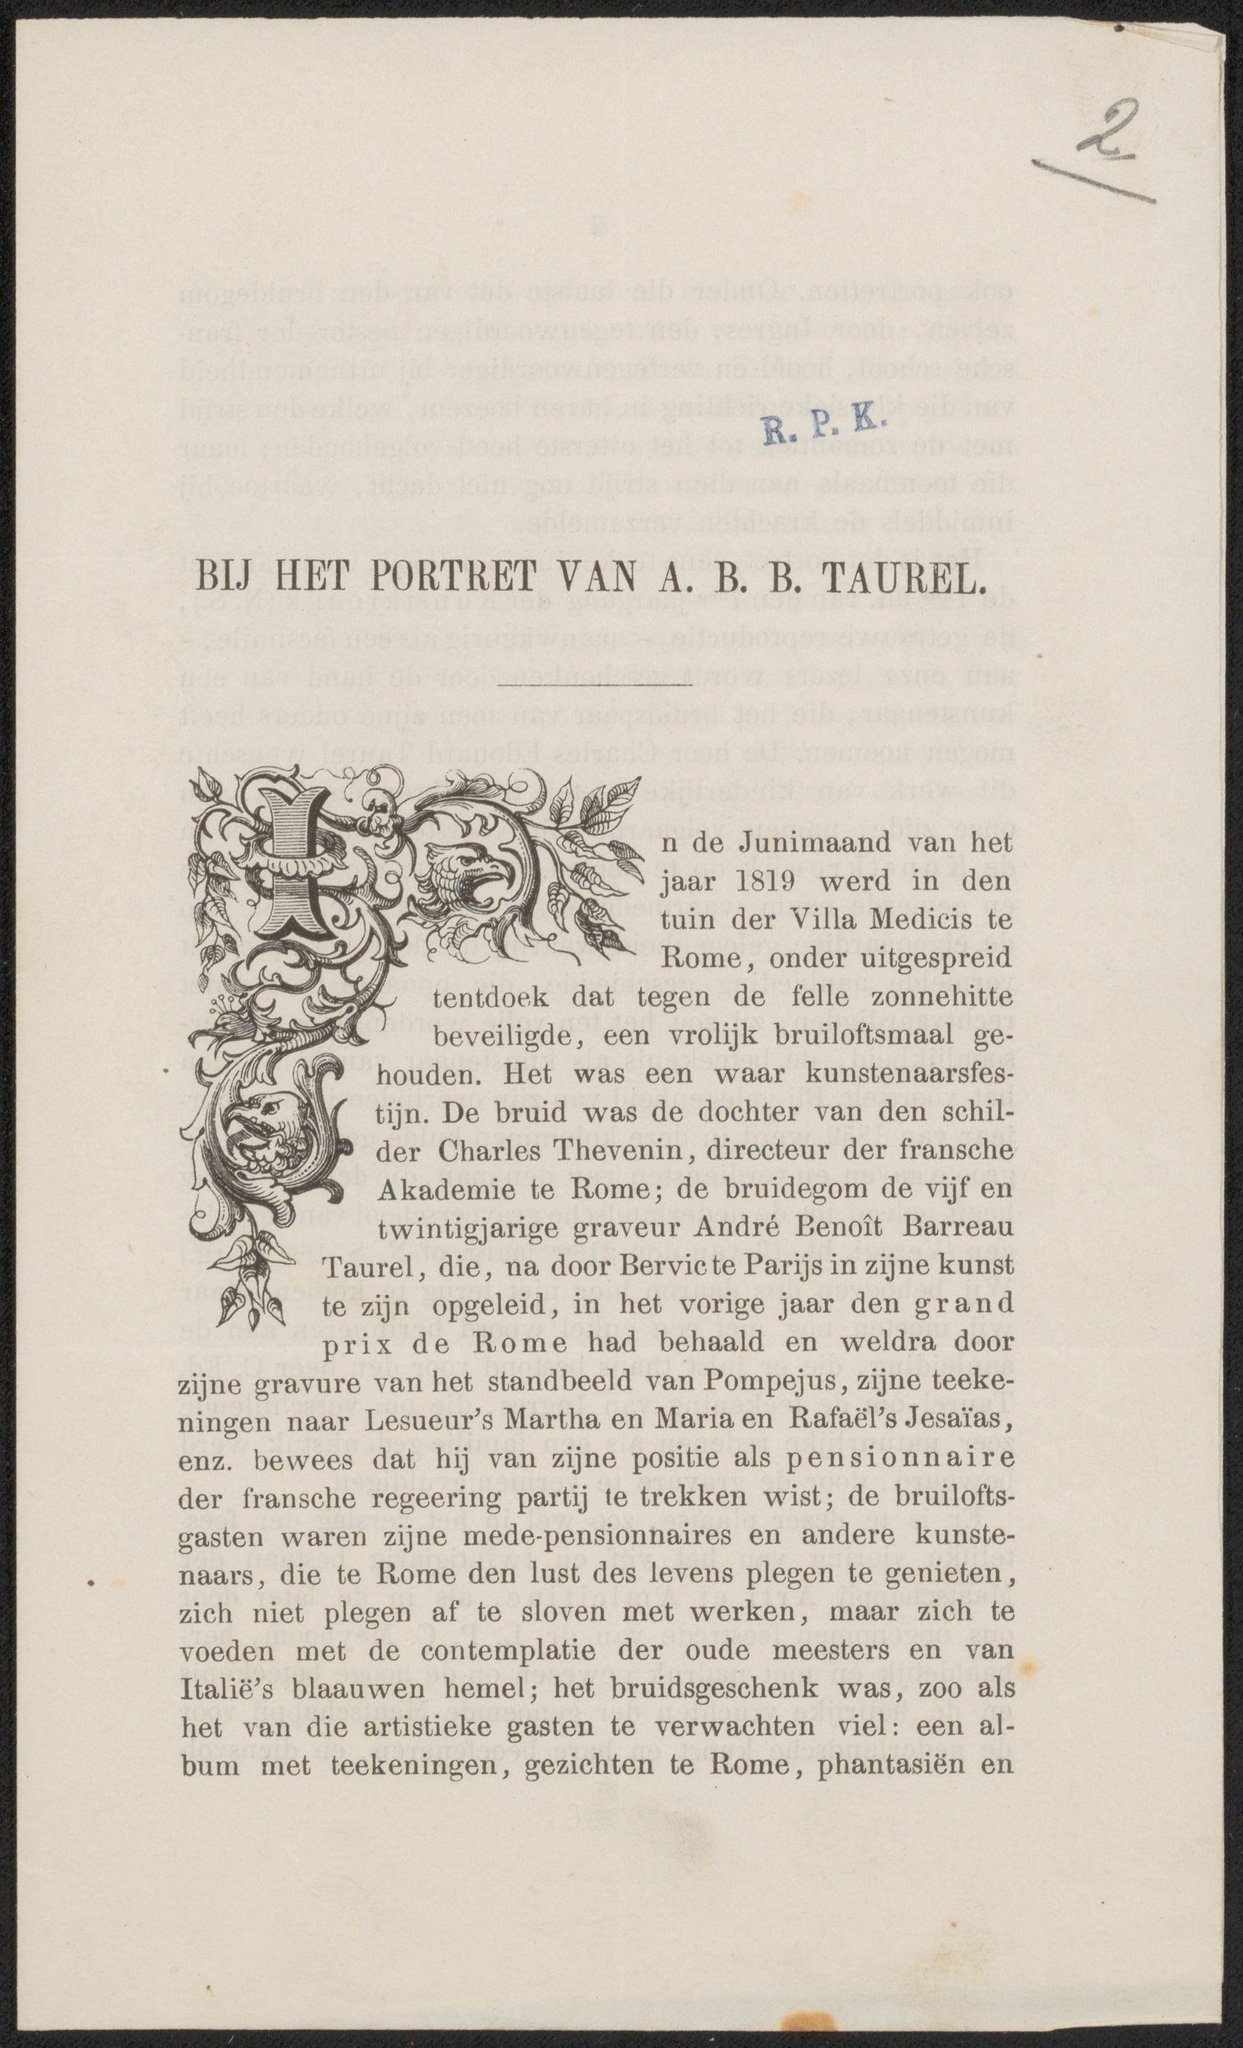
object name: article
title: Artikel betreffende Benoit Taurel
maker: Anonymous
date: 1806-1865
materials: paper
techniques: printing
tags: paris, amsterdam, print maker, draughtsman, edouard taurel, benoit taurel, jean auguste dominique ingres, historical persons (portraits and scenes from the life)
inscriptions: collector's mark: Lugt 2233